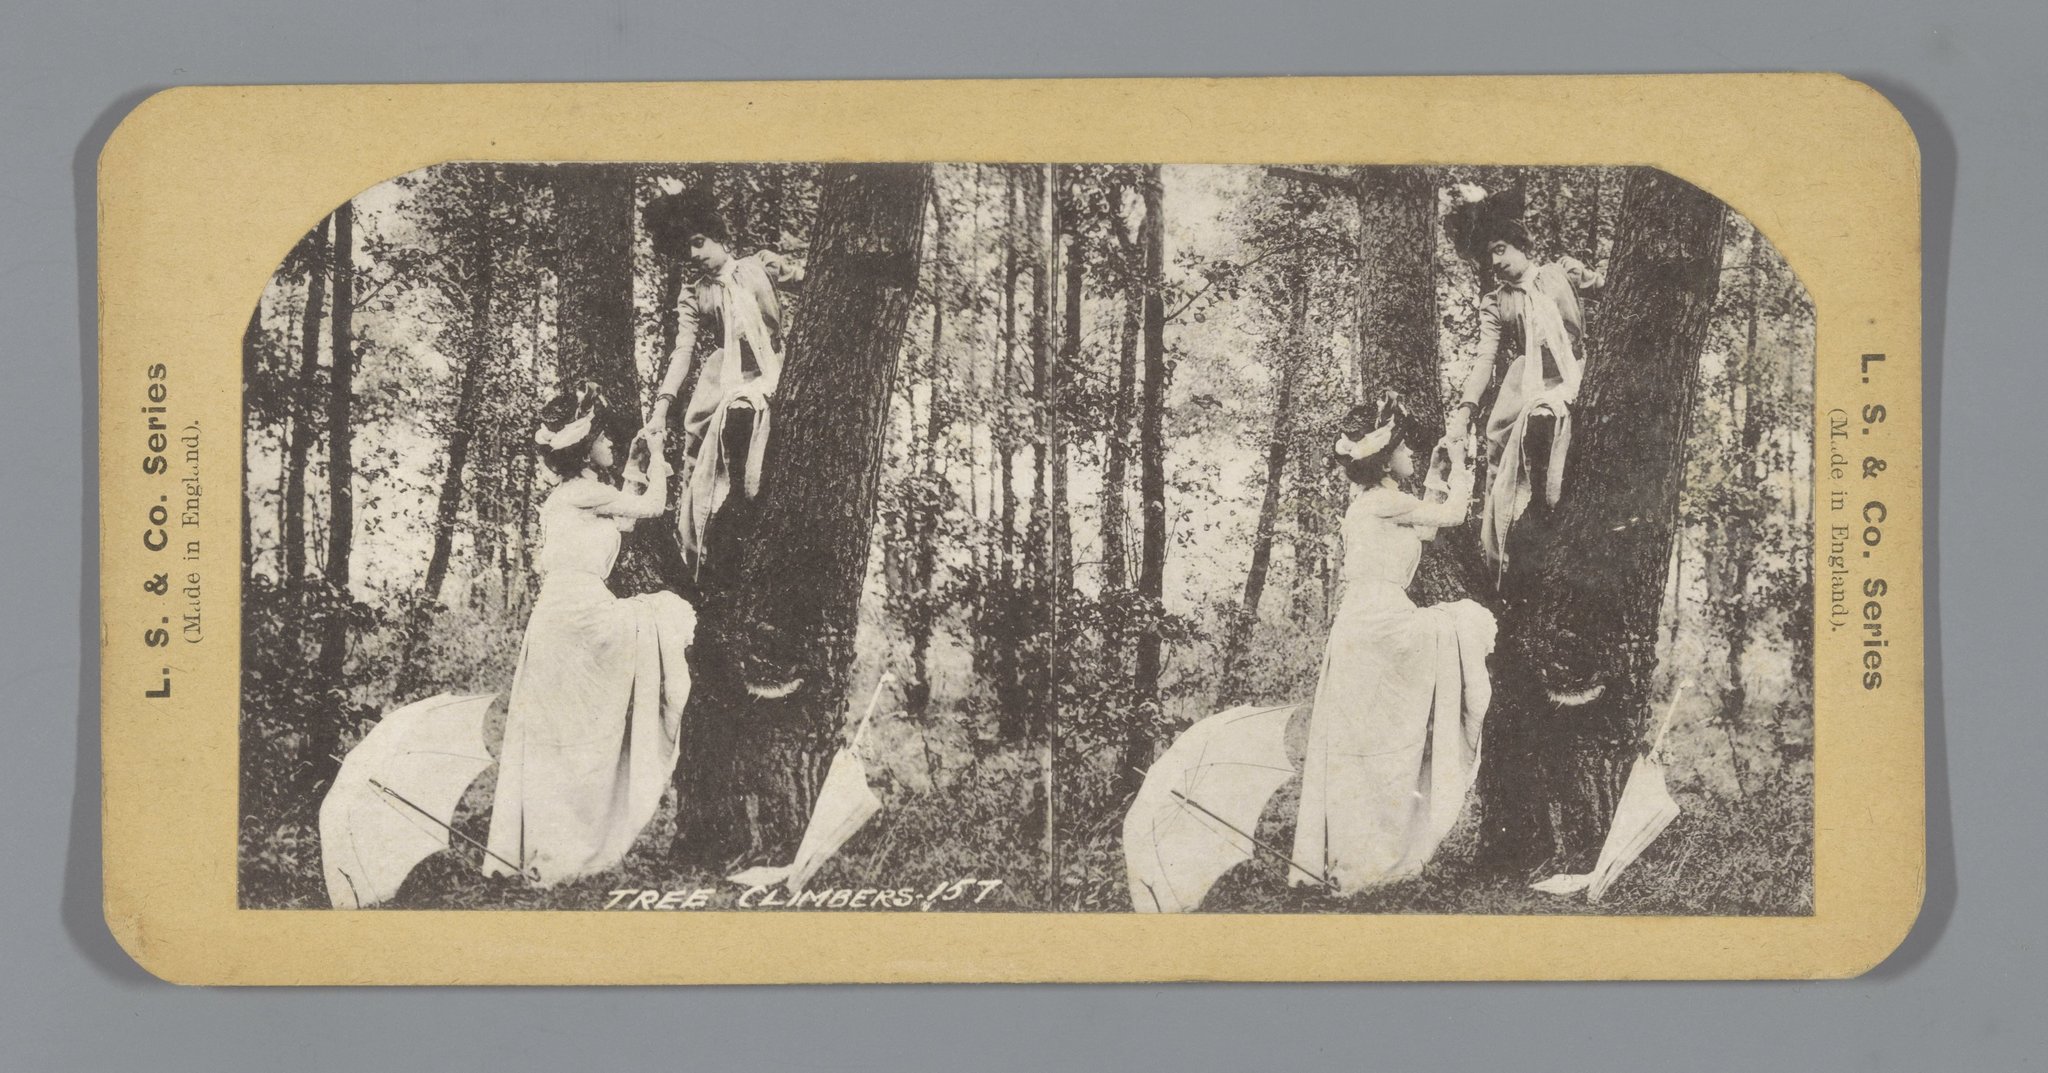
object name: stereograph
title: Tafereel met twee mensen die een boom beklimmen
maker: Anonymous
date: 1870-1890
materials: cardboard, photographic support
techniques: photograph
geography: london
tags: trees, adult woman, adult man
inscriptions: retailer's mark: ‘JK’, number: ‘157’